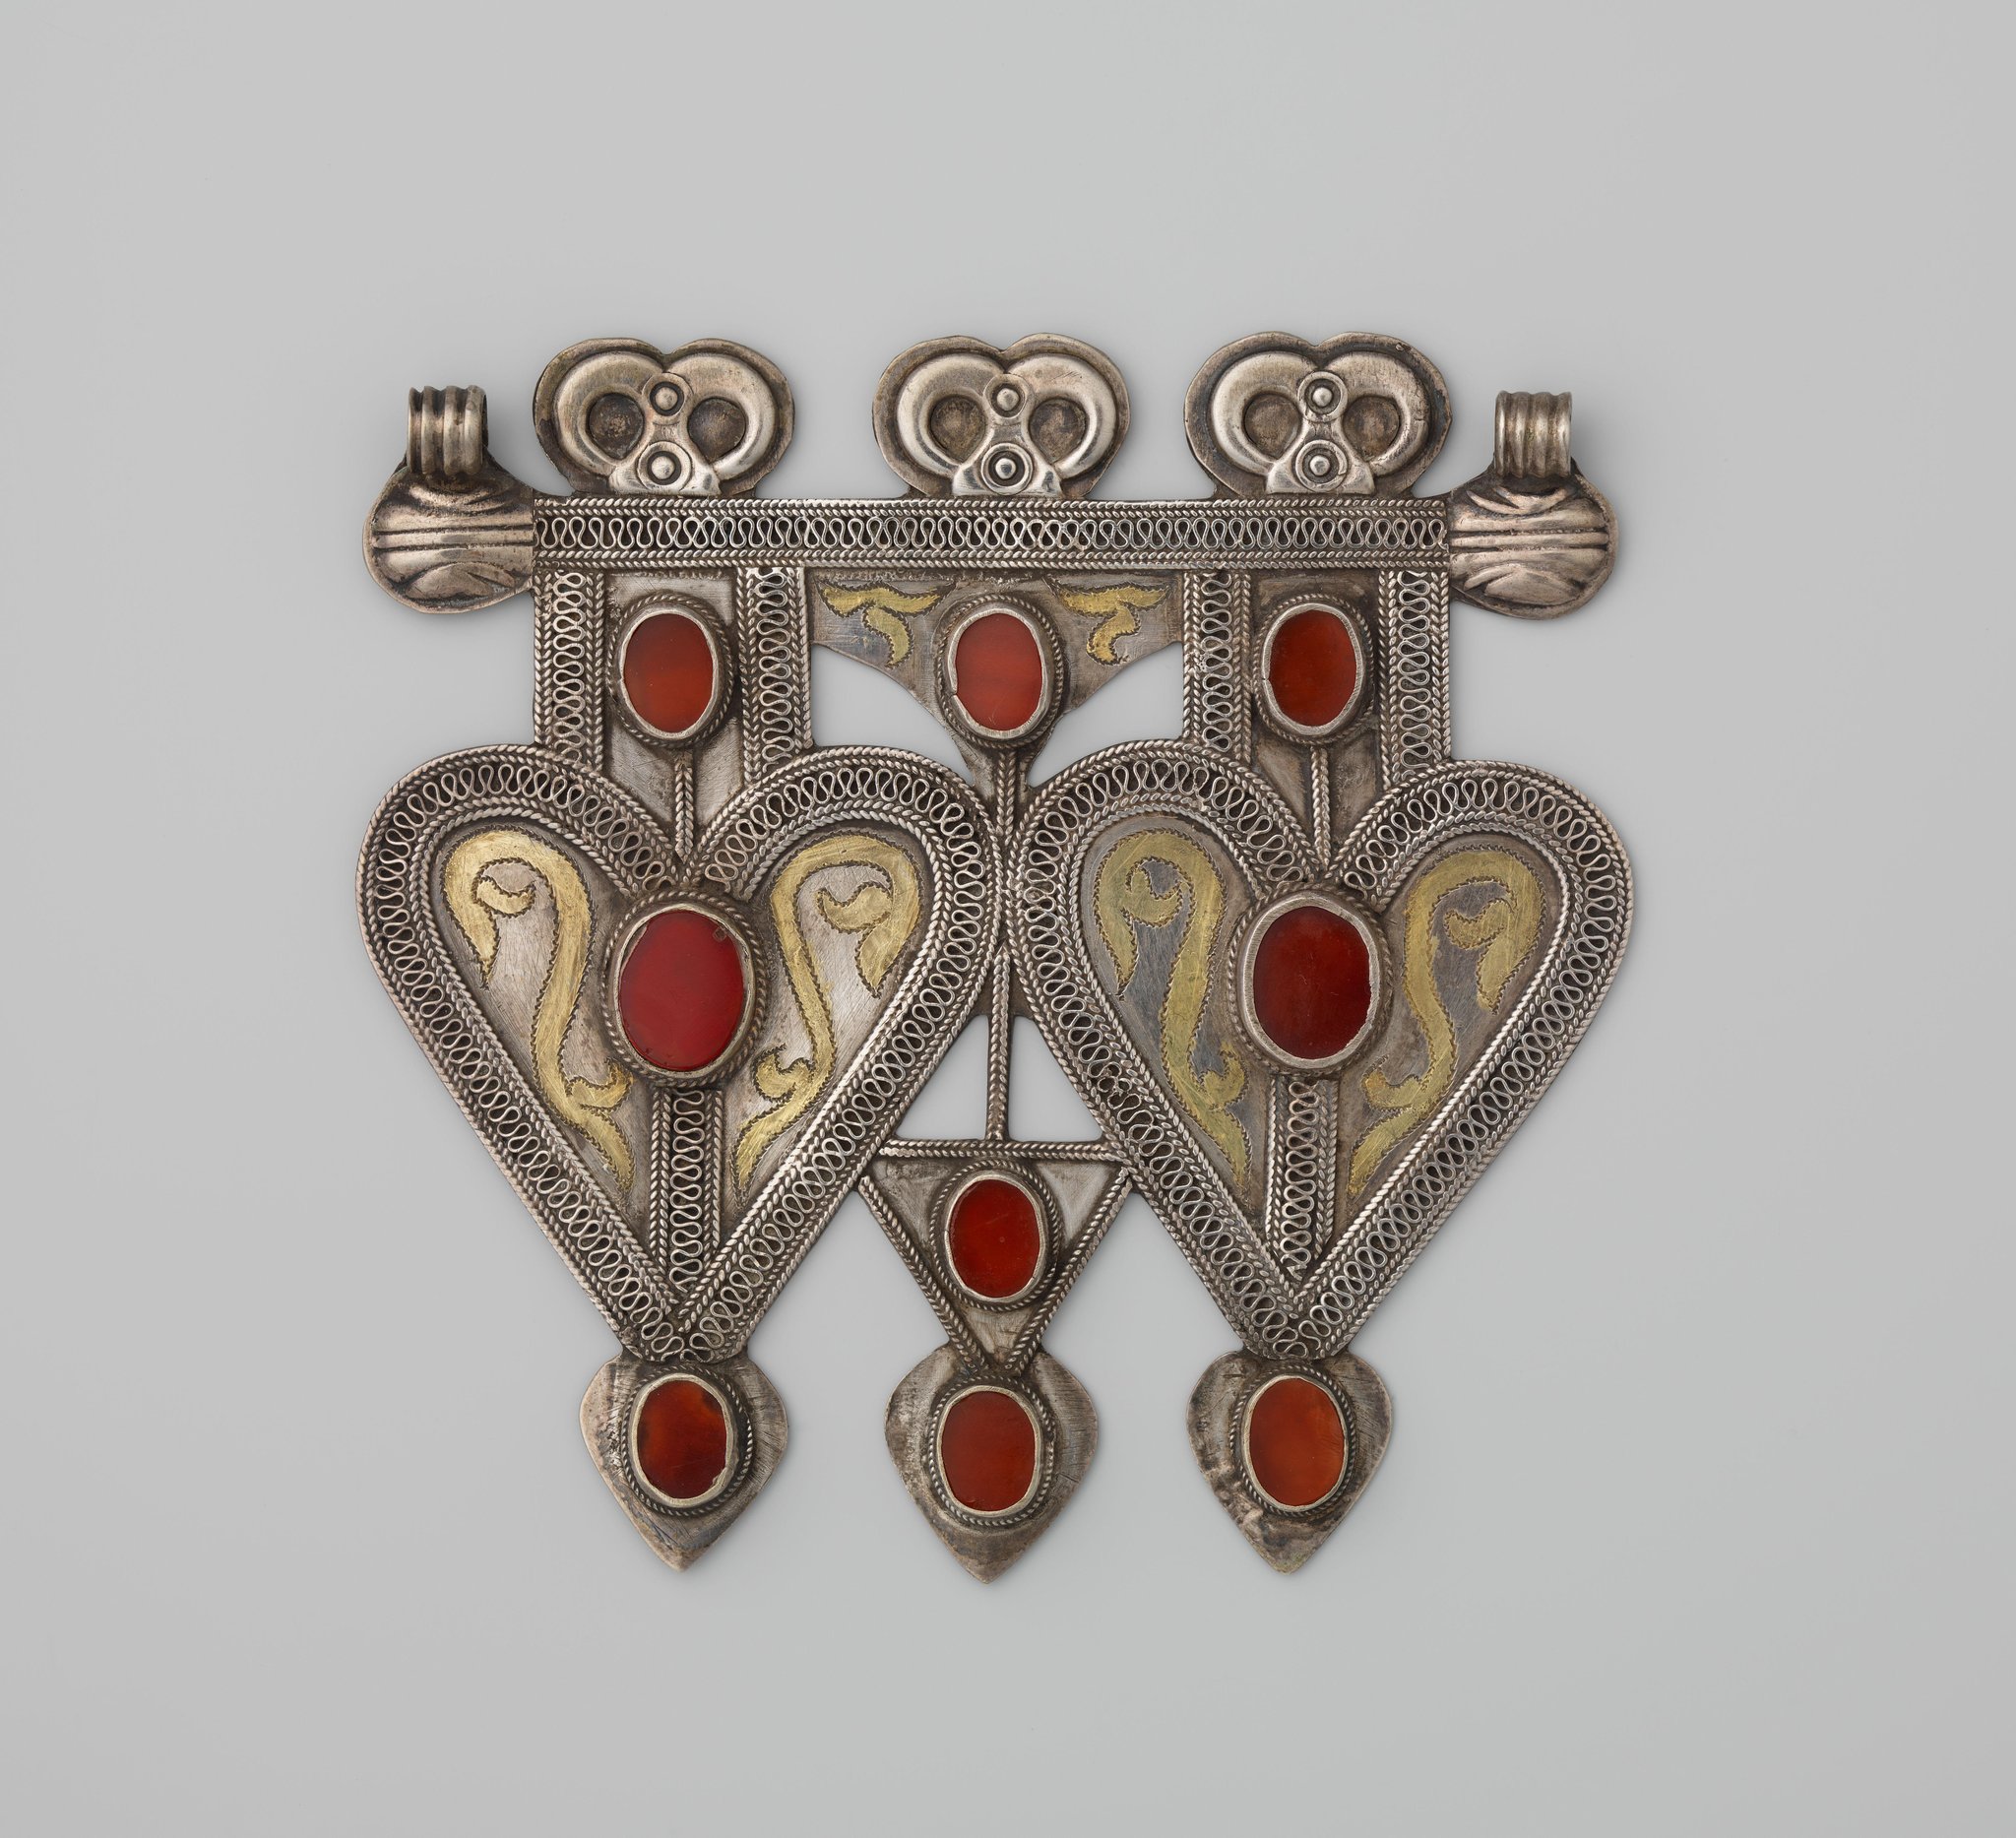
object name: pendant jewelry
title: Rug pendant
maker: Anonymous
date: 1900-2000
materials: gemstone, silver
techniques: casting, grinding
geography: afghanistan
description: Rug pendant van zilver met negen vlak geslepen carneolen.